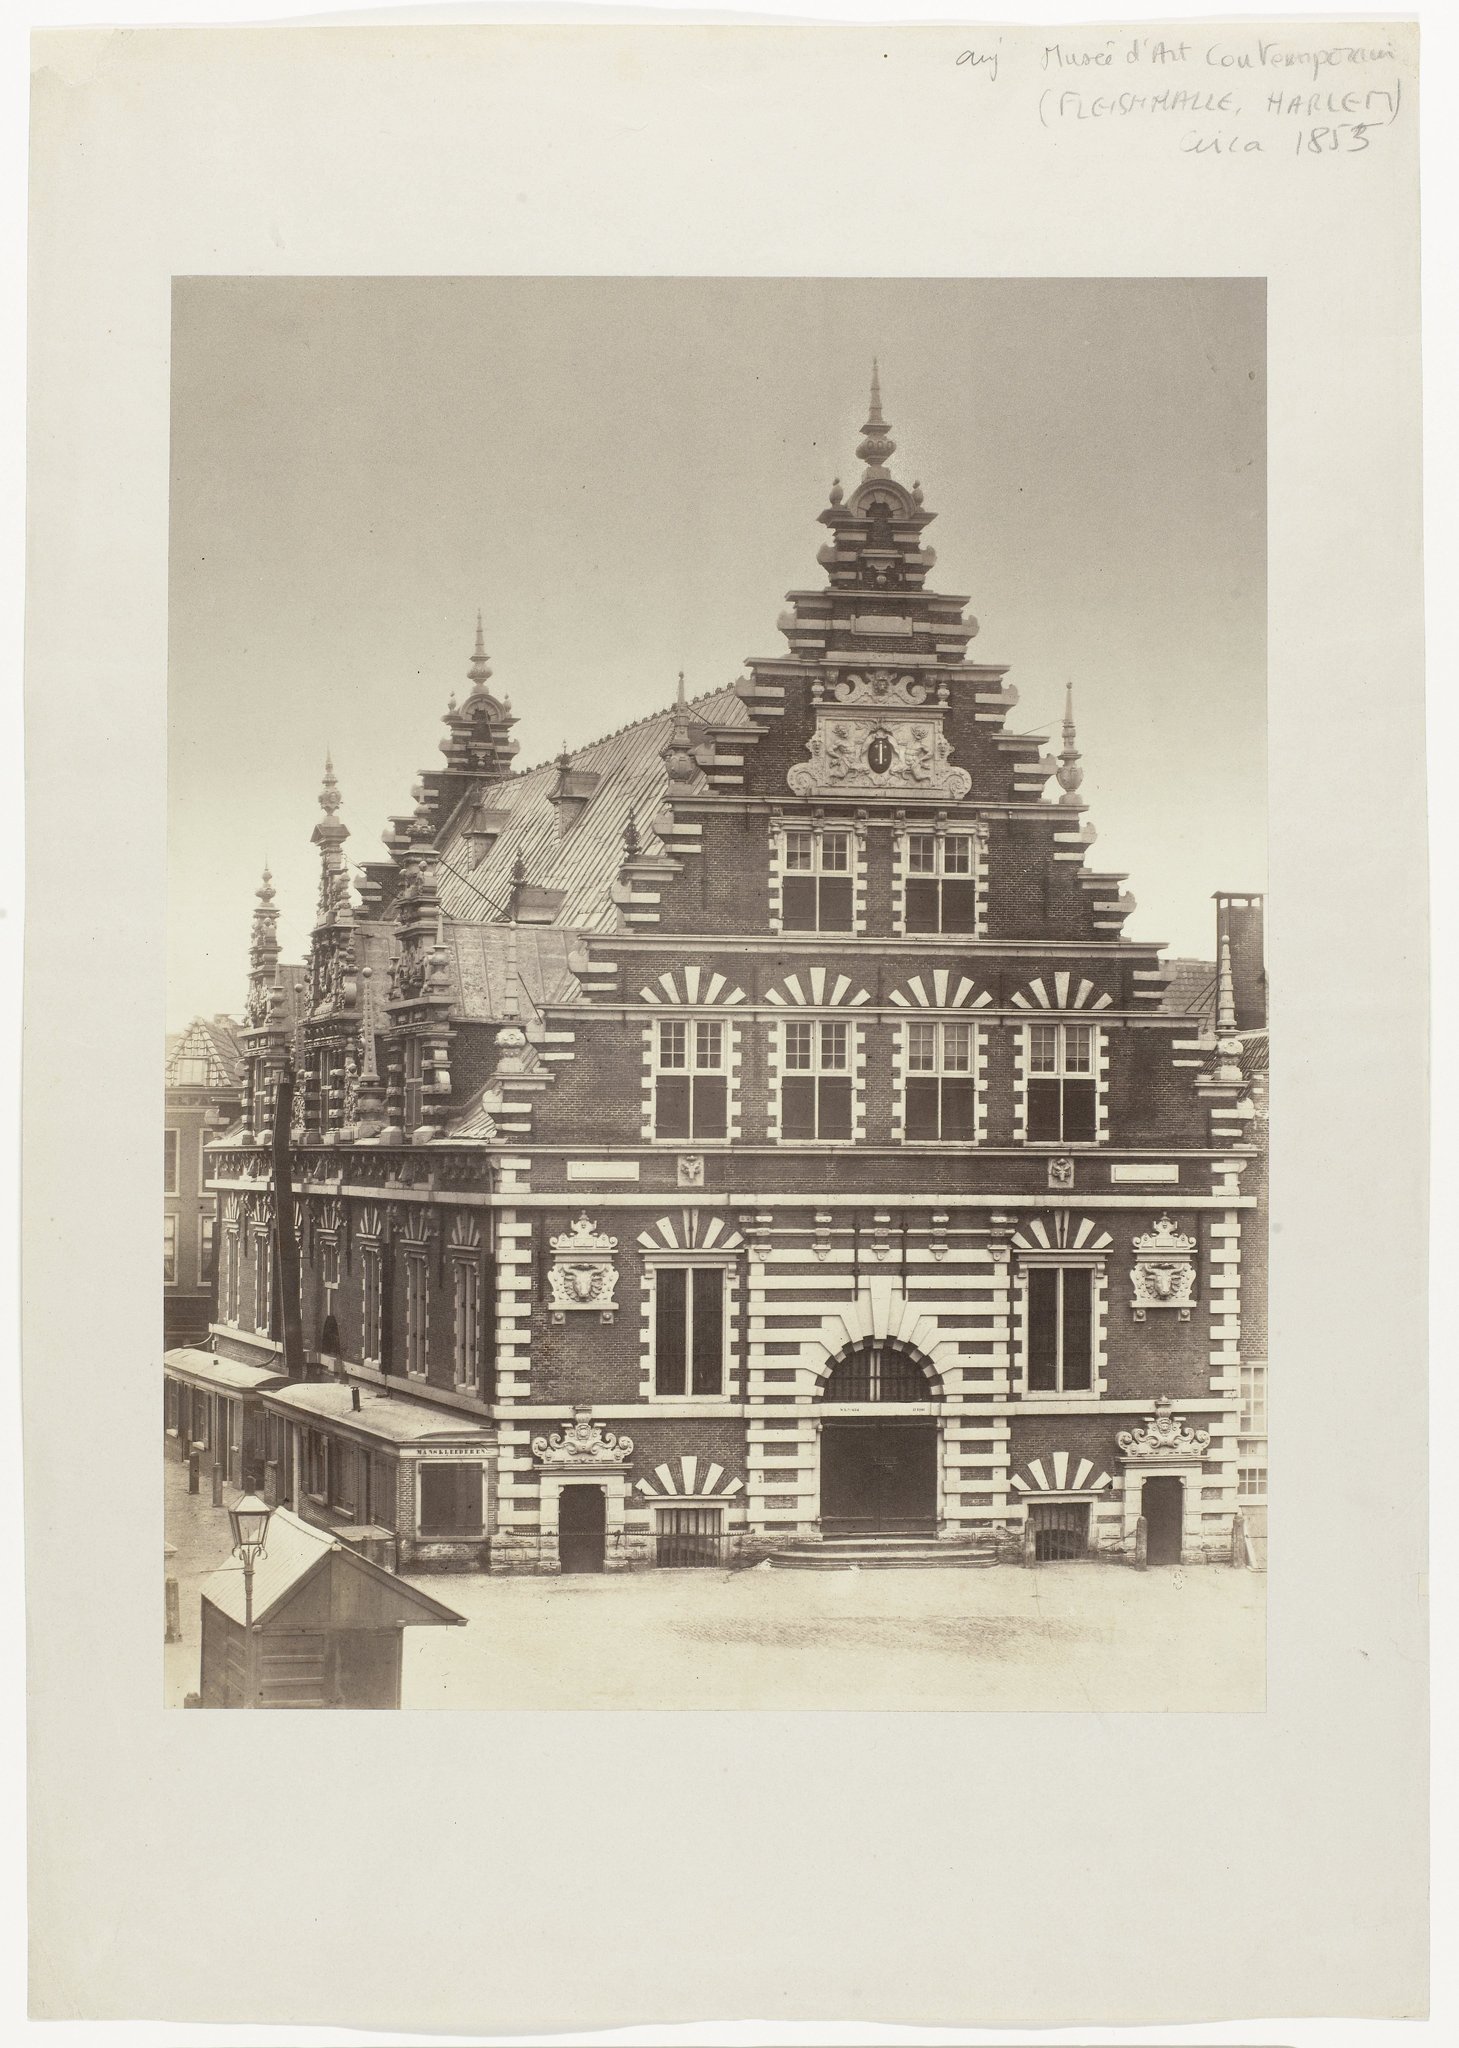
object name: photograph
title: Gezicht op de Vleeshal in Haarlem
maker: Anonymous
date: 1855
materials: paper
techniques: salted paper print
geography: haarlem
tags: exterior ~ representation of a building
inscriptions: inscription: ‘anj Musée d'Art Contemporain/ (FLEISCHHALLE, HARLEM)/ circa 1855’